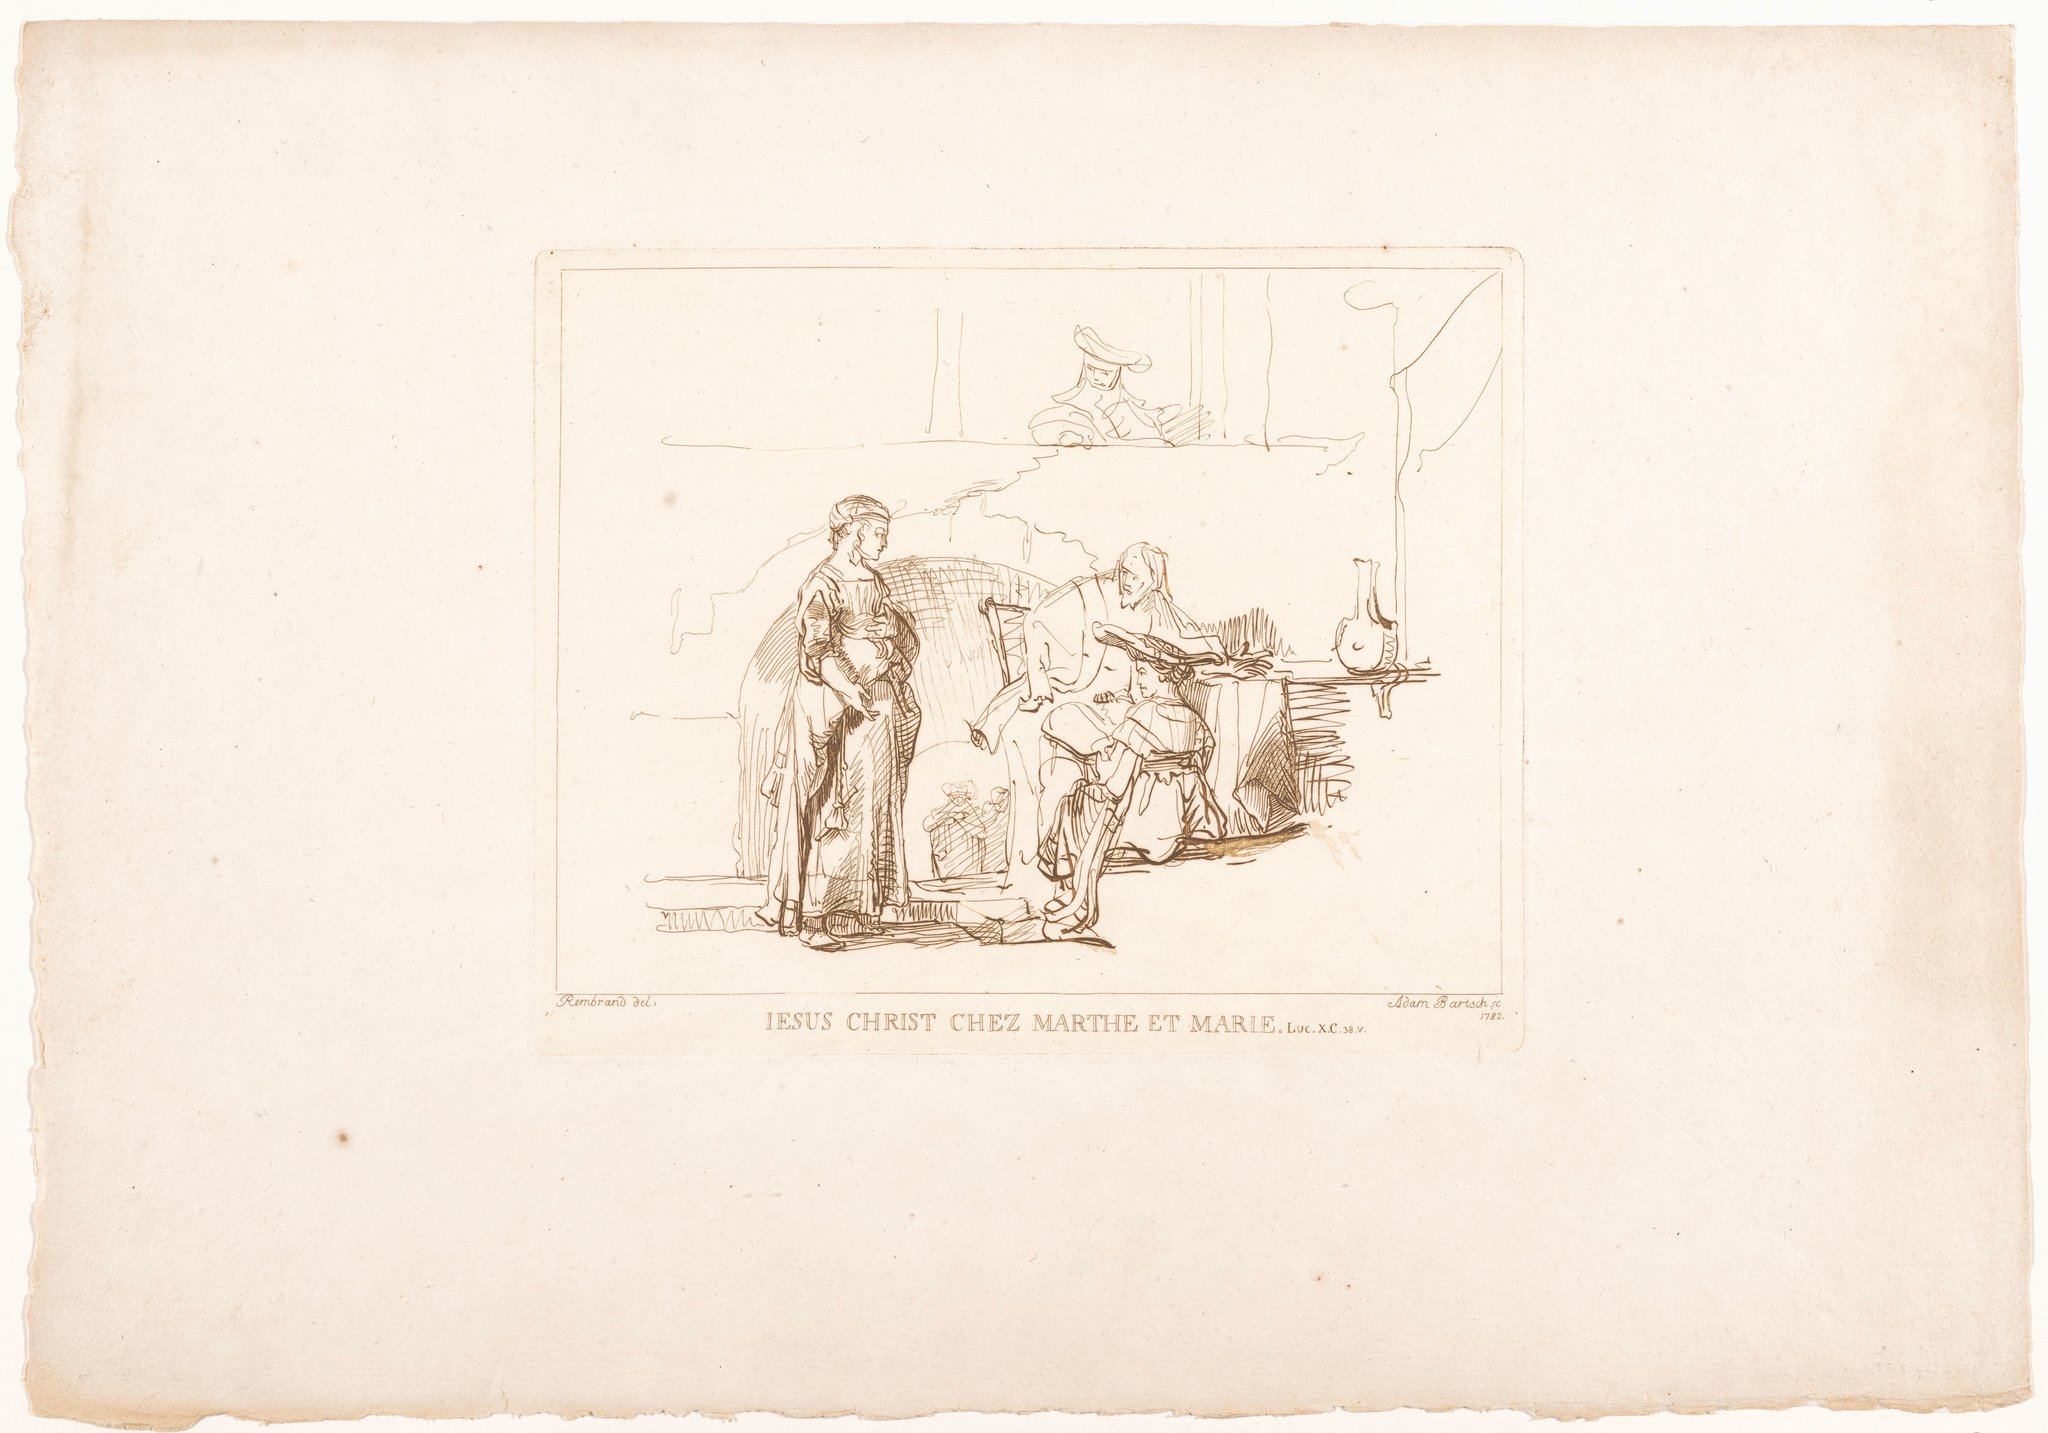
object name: print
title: Jesus Christ chez Marthe et Marie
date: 1782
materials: paper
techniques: etching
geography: vienna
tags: christ in the house of martha and mary (luke 10:38-42)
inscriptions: collector's mark: Lugt 240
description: Vierde prent uit de serie 'Six estampes gravées d'après les desseins originaux de Rembrand qui se trouvent dans la collection de la Bibliothèque Imp. et Roy. de Vienne', bestaand uit een titelprent en zes prenten.